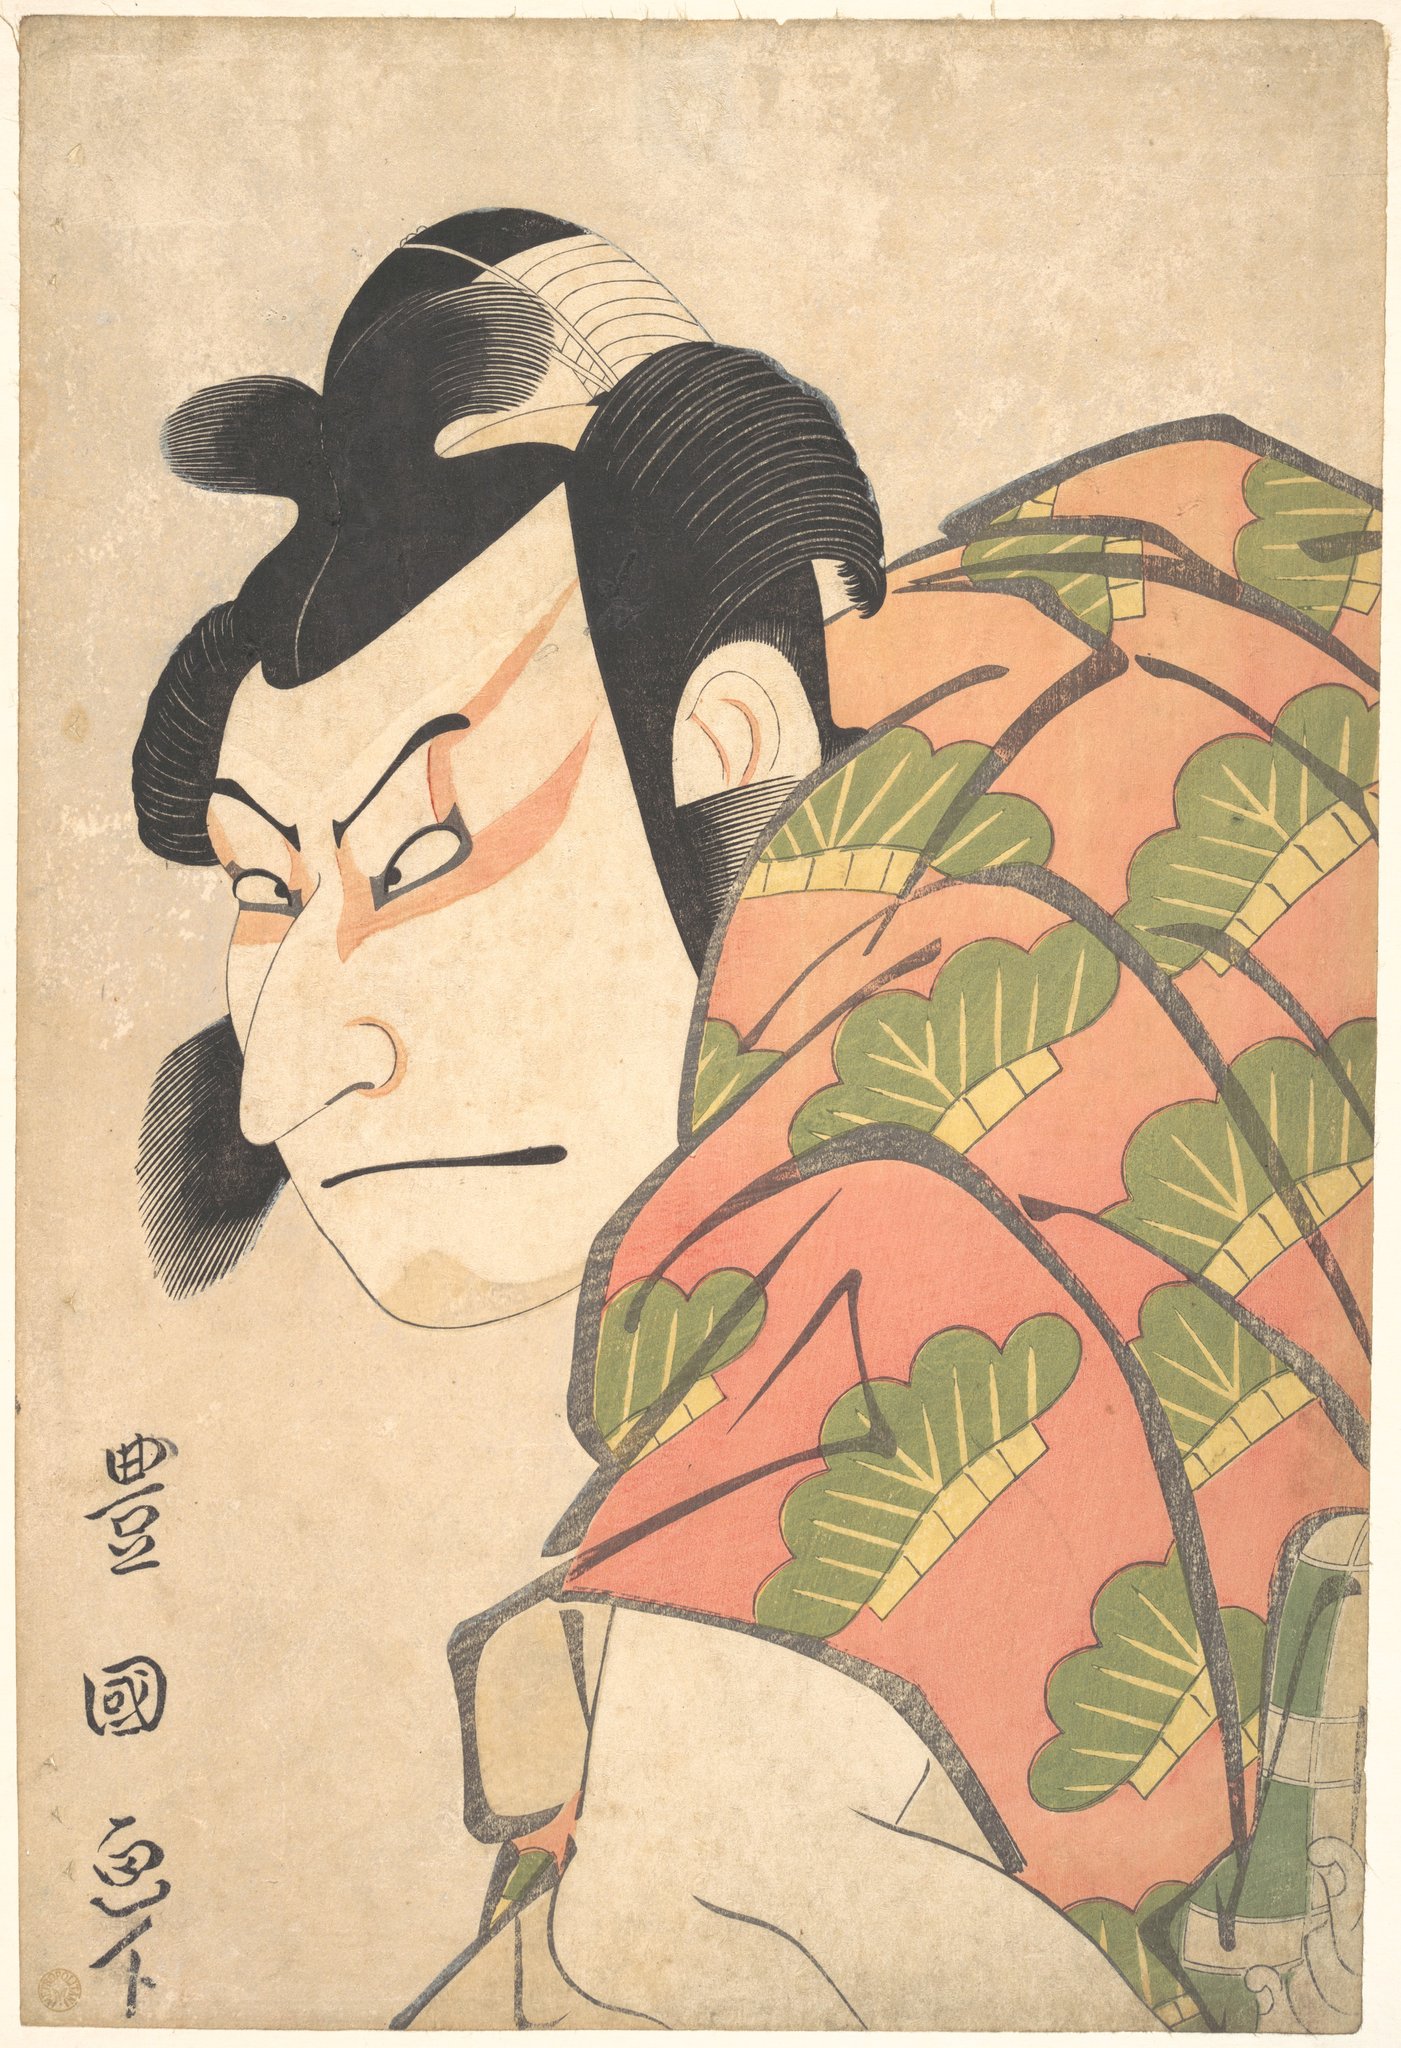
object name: print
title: Nakamura Nakazo II as Matsuo-maru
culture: japanese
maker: utagawa toyokuni i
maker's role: artist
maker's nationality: japanese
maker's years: 1769-1825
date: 1796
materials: ink, paper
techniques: woodblock print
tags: men,actors